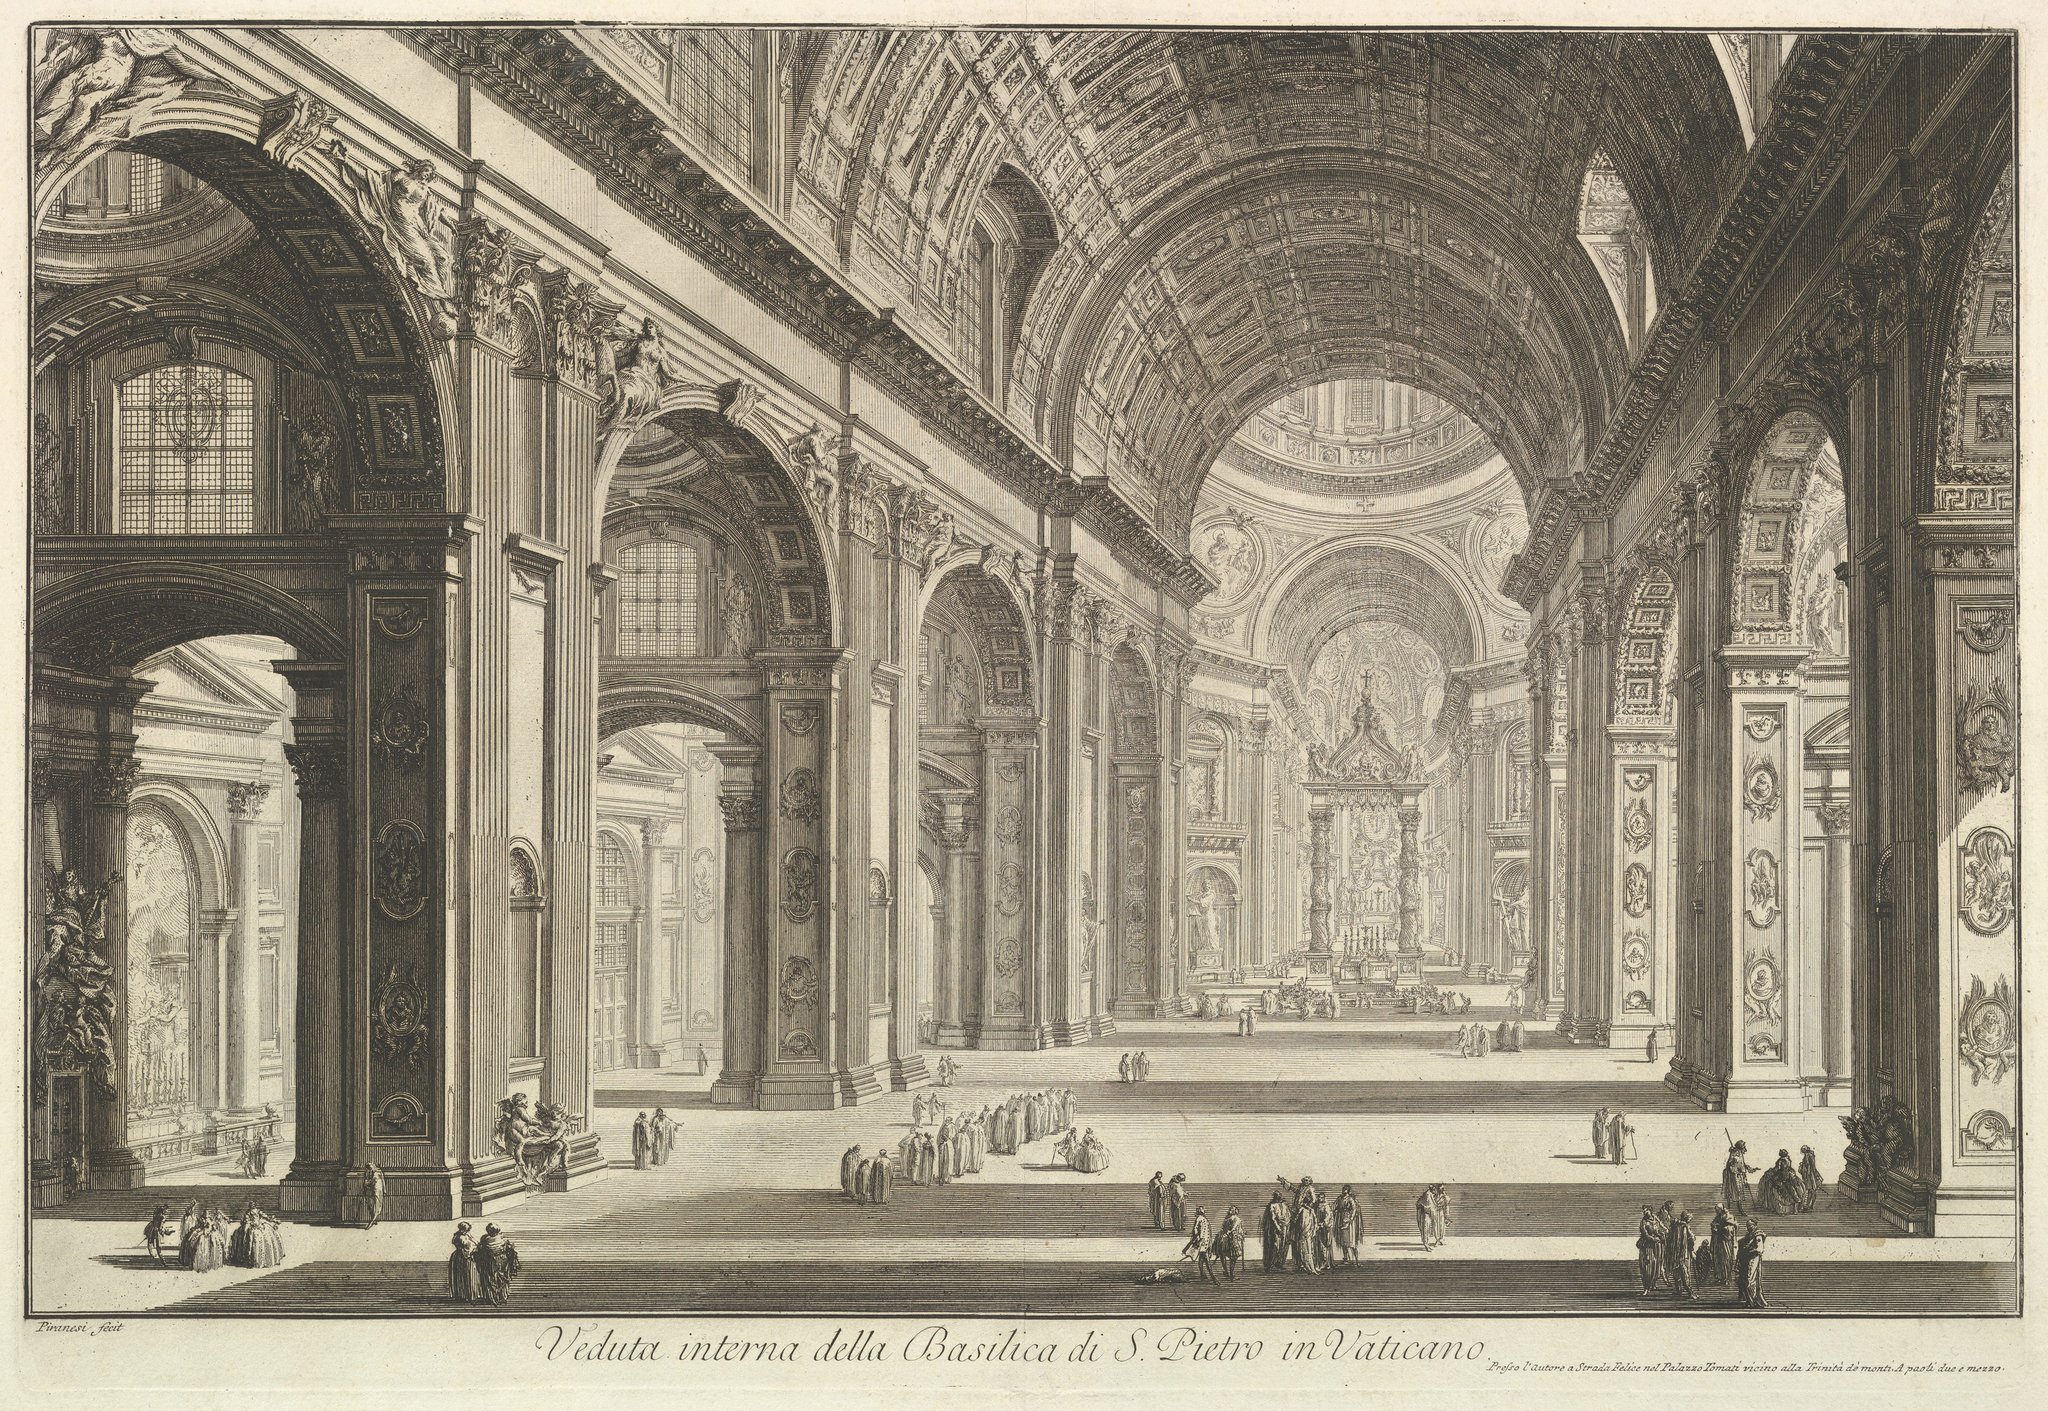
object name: print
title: Interior view of St. Peter's Basilica in the Vatican, from "Vedute di Roma" (Roman Views)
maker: giovanni battista piranesi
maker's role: artist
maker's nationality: italian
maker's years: 1720-1778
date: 1748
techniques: etching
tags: interiors,churches,rome